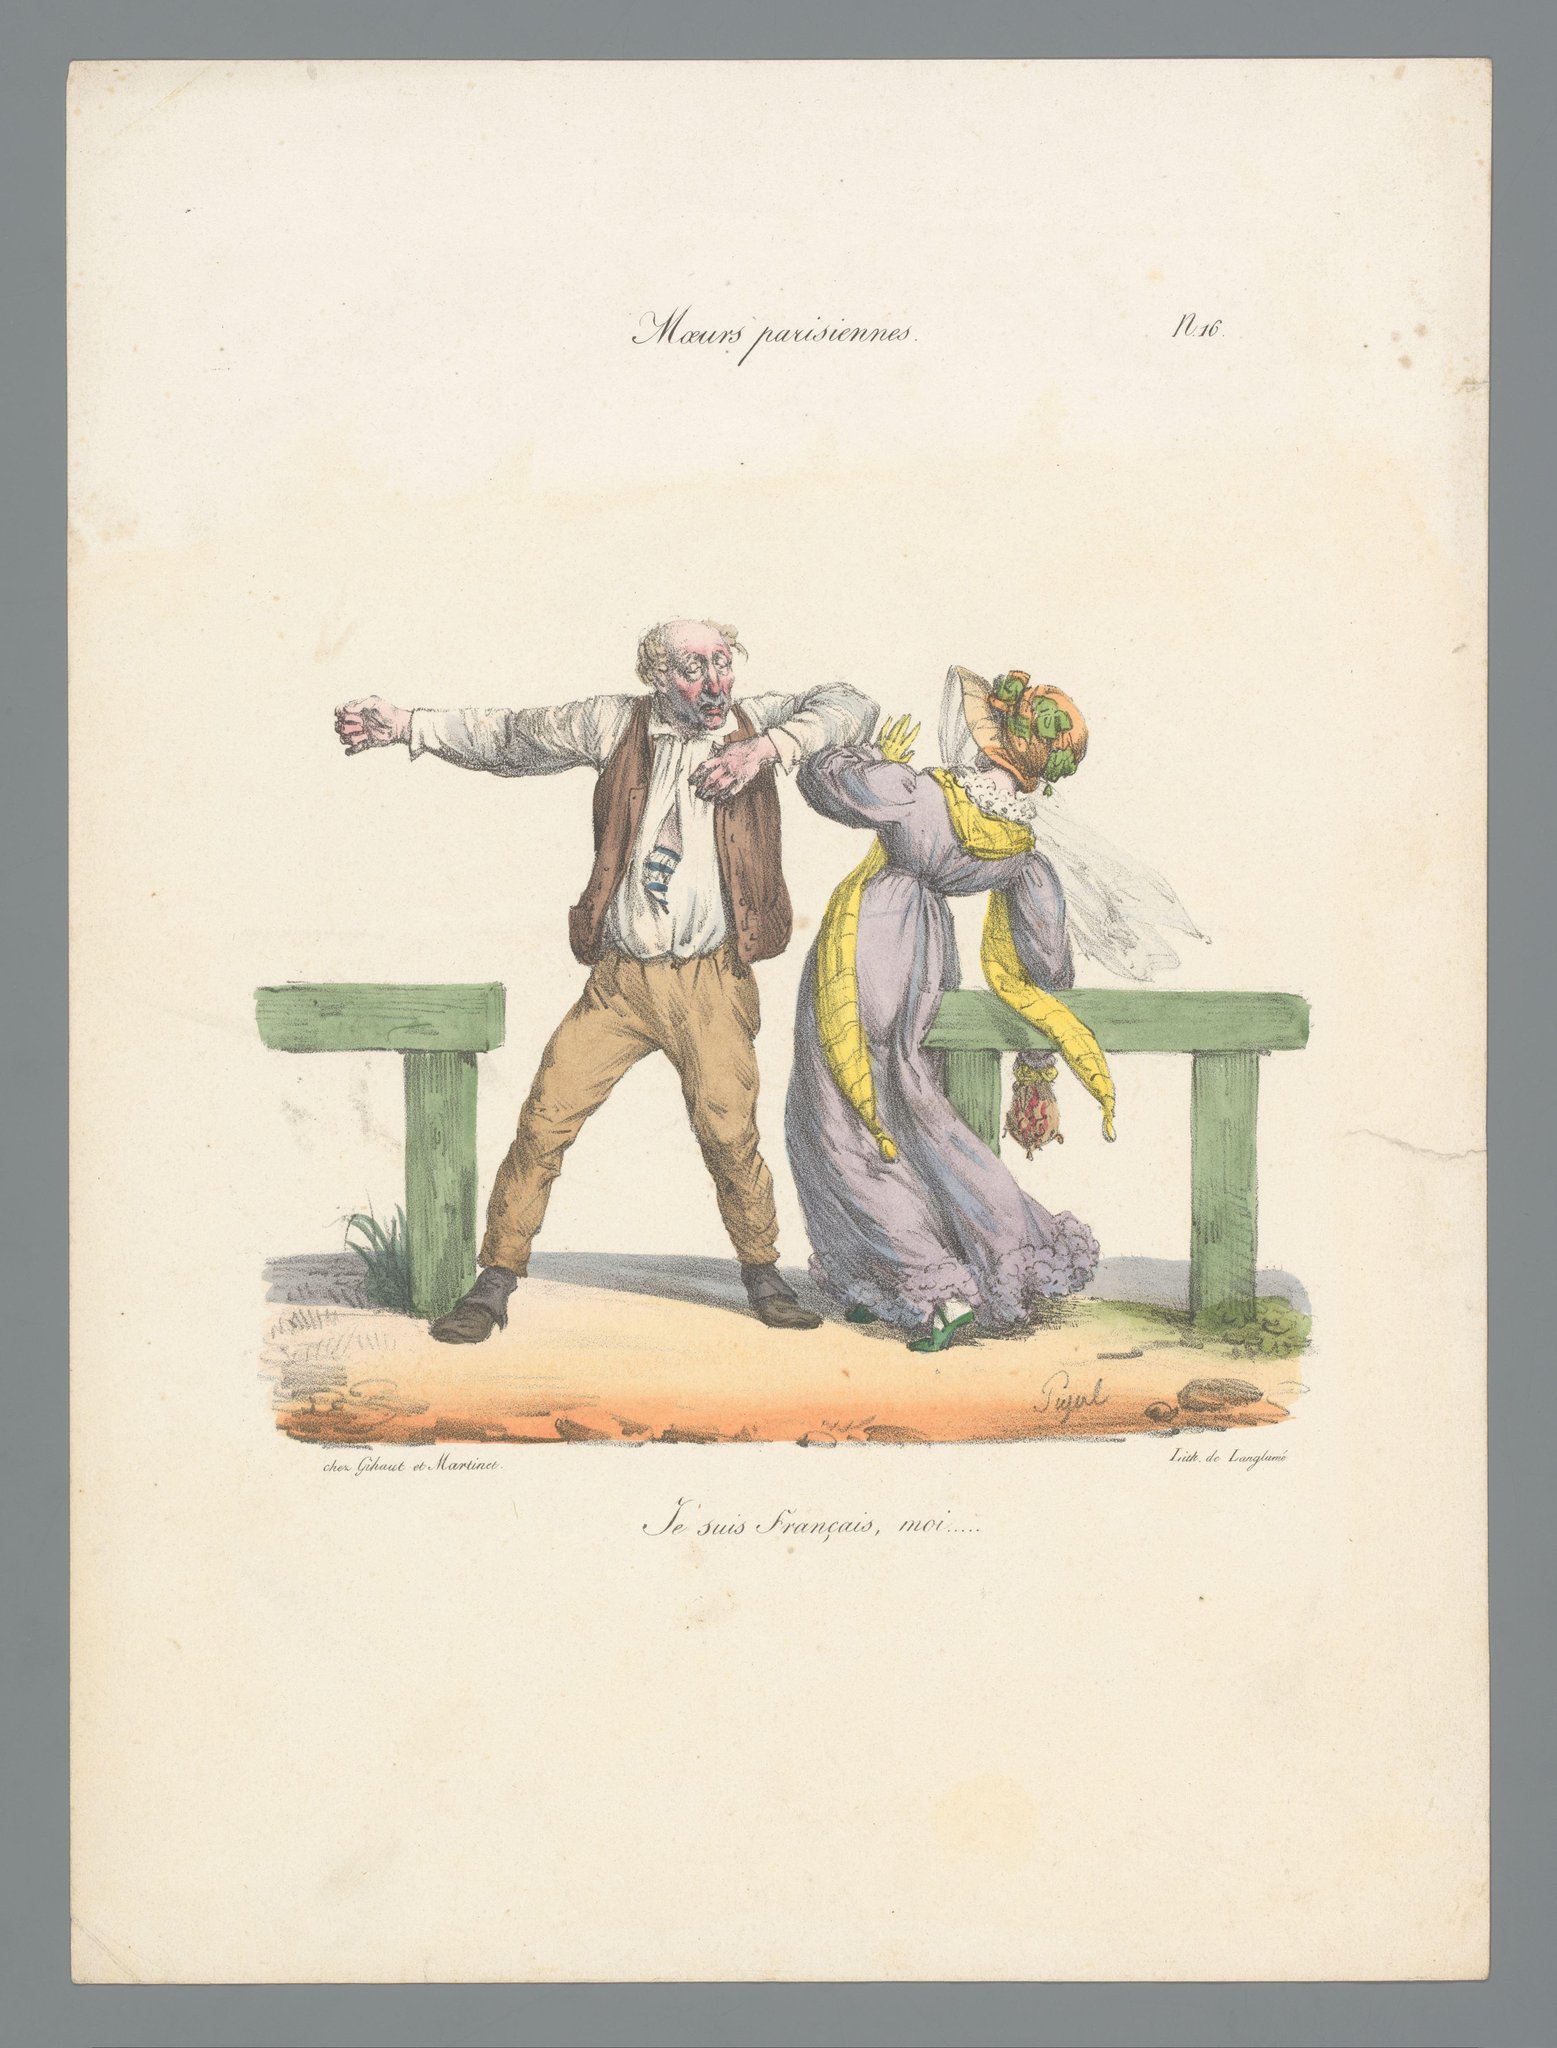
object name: print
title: Slonzig geklede man en elegant geklede vrouw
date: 1825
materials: paper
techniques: hand coloring, lithograph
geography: paris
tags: adult woman, adult man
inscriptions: collector's mark: Lugt 2228